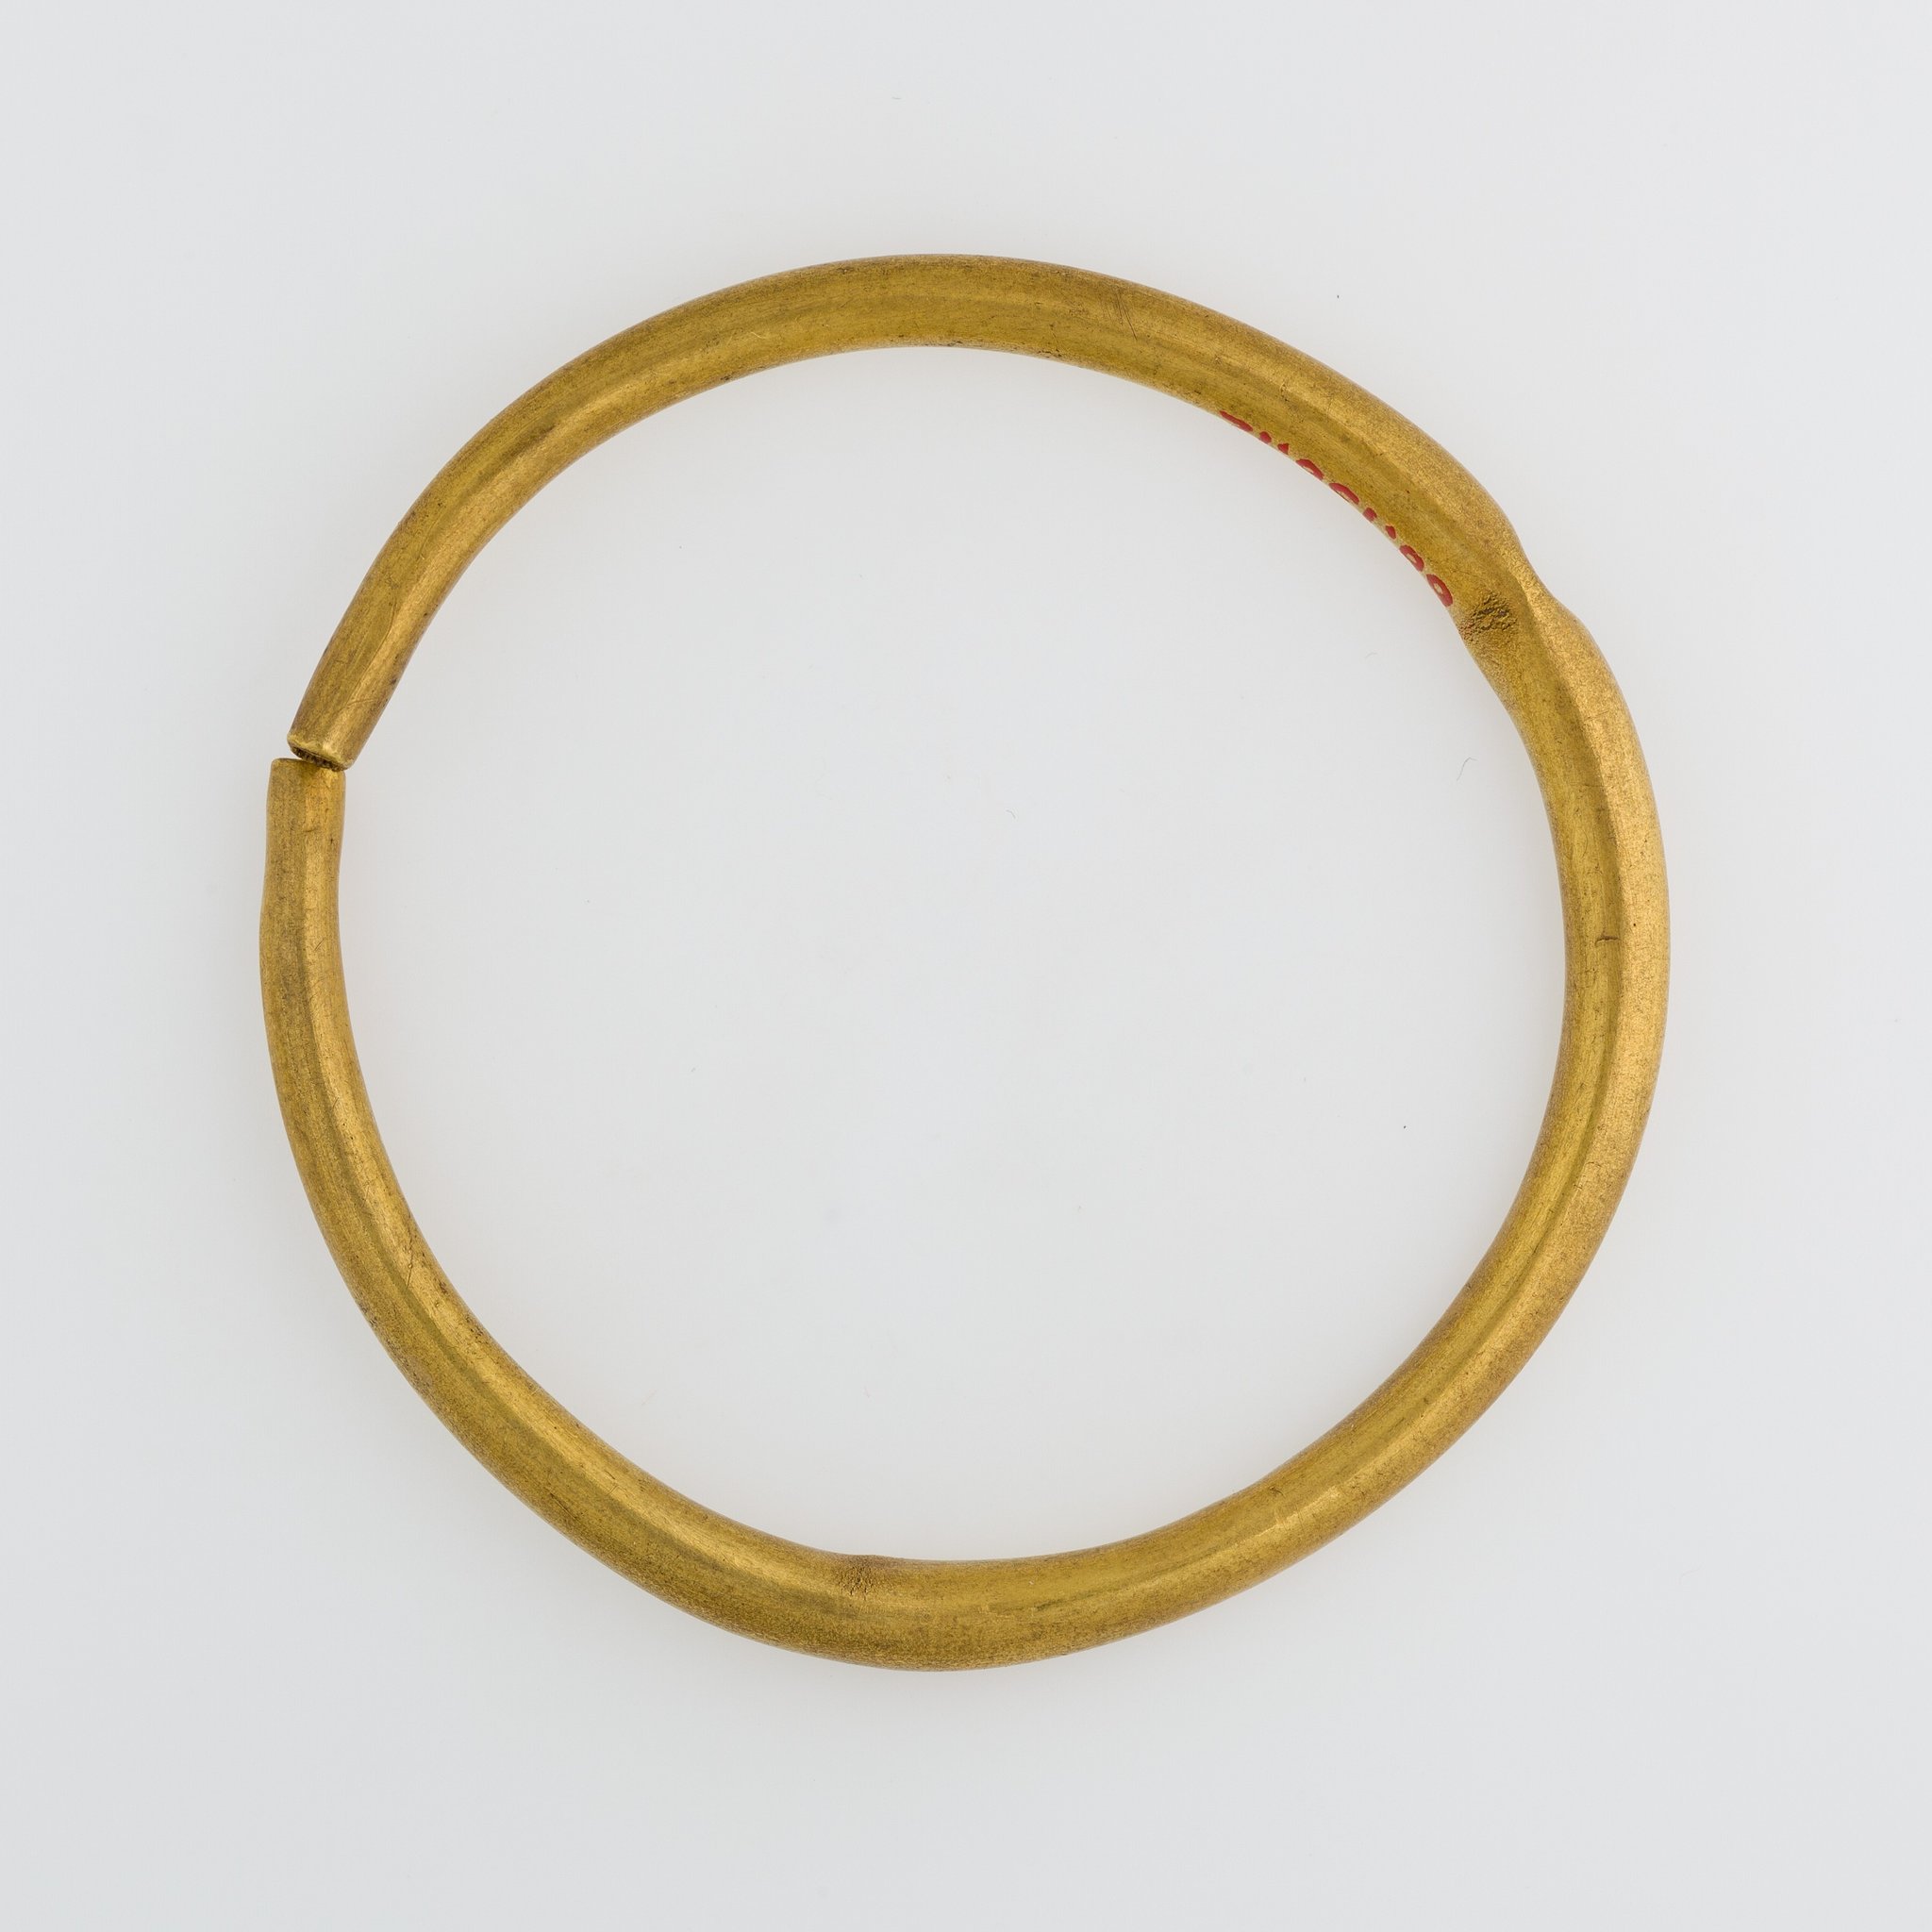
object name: earring, hoop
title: Hoop Earring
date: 1648-1540 BCE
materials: gold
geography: eastern delta